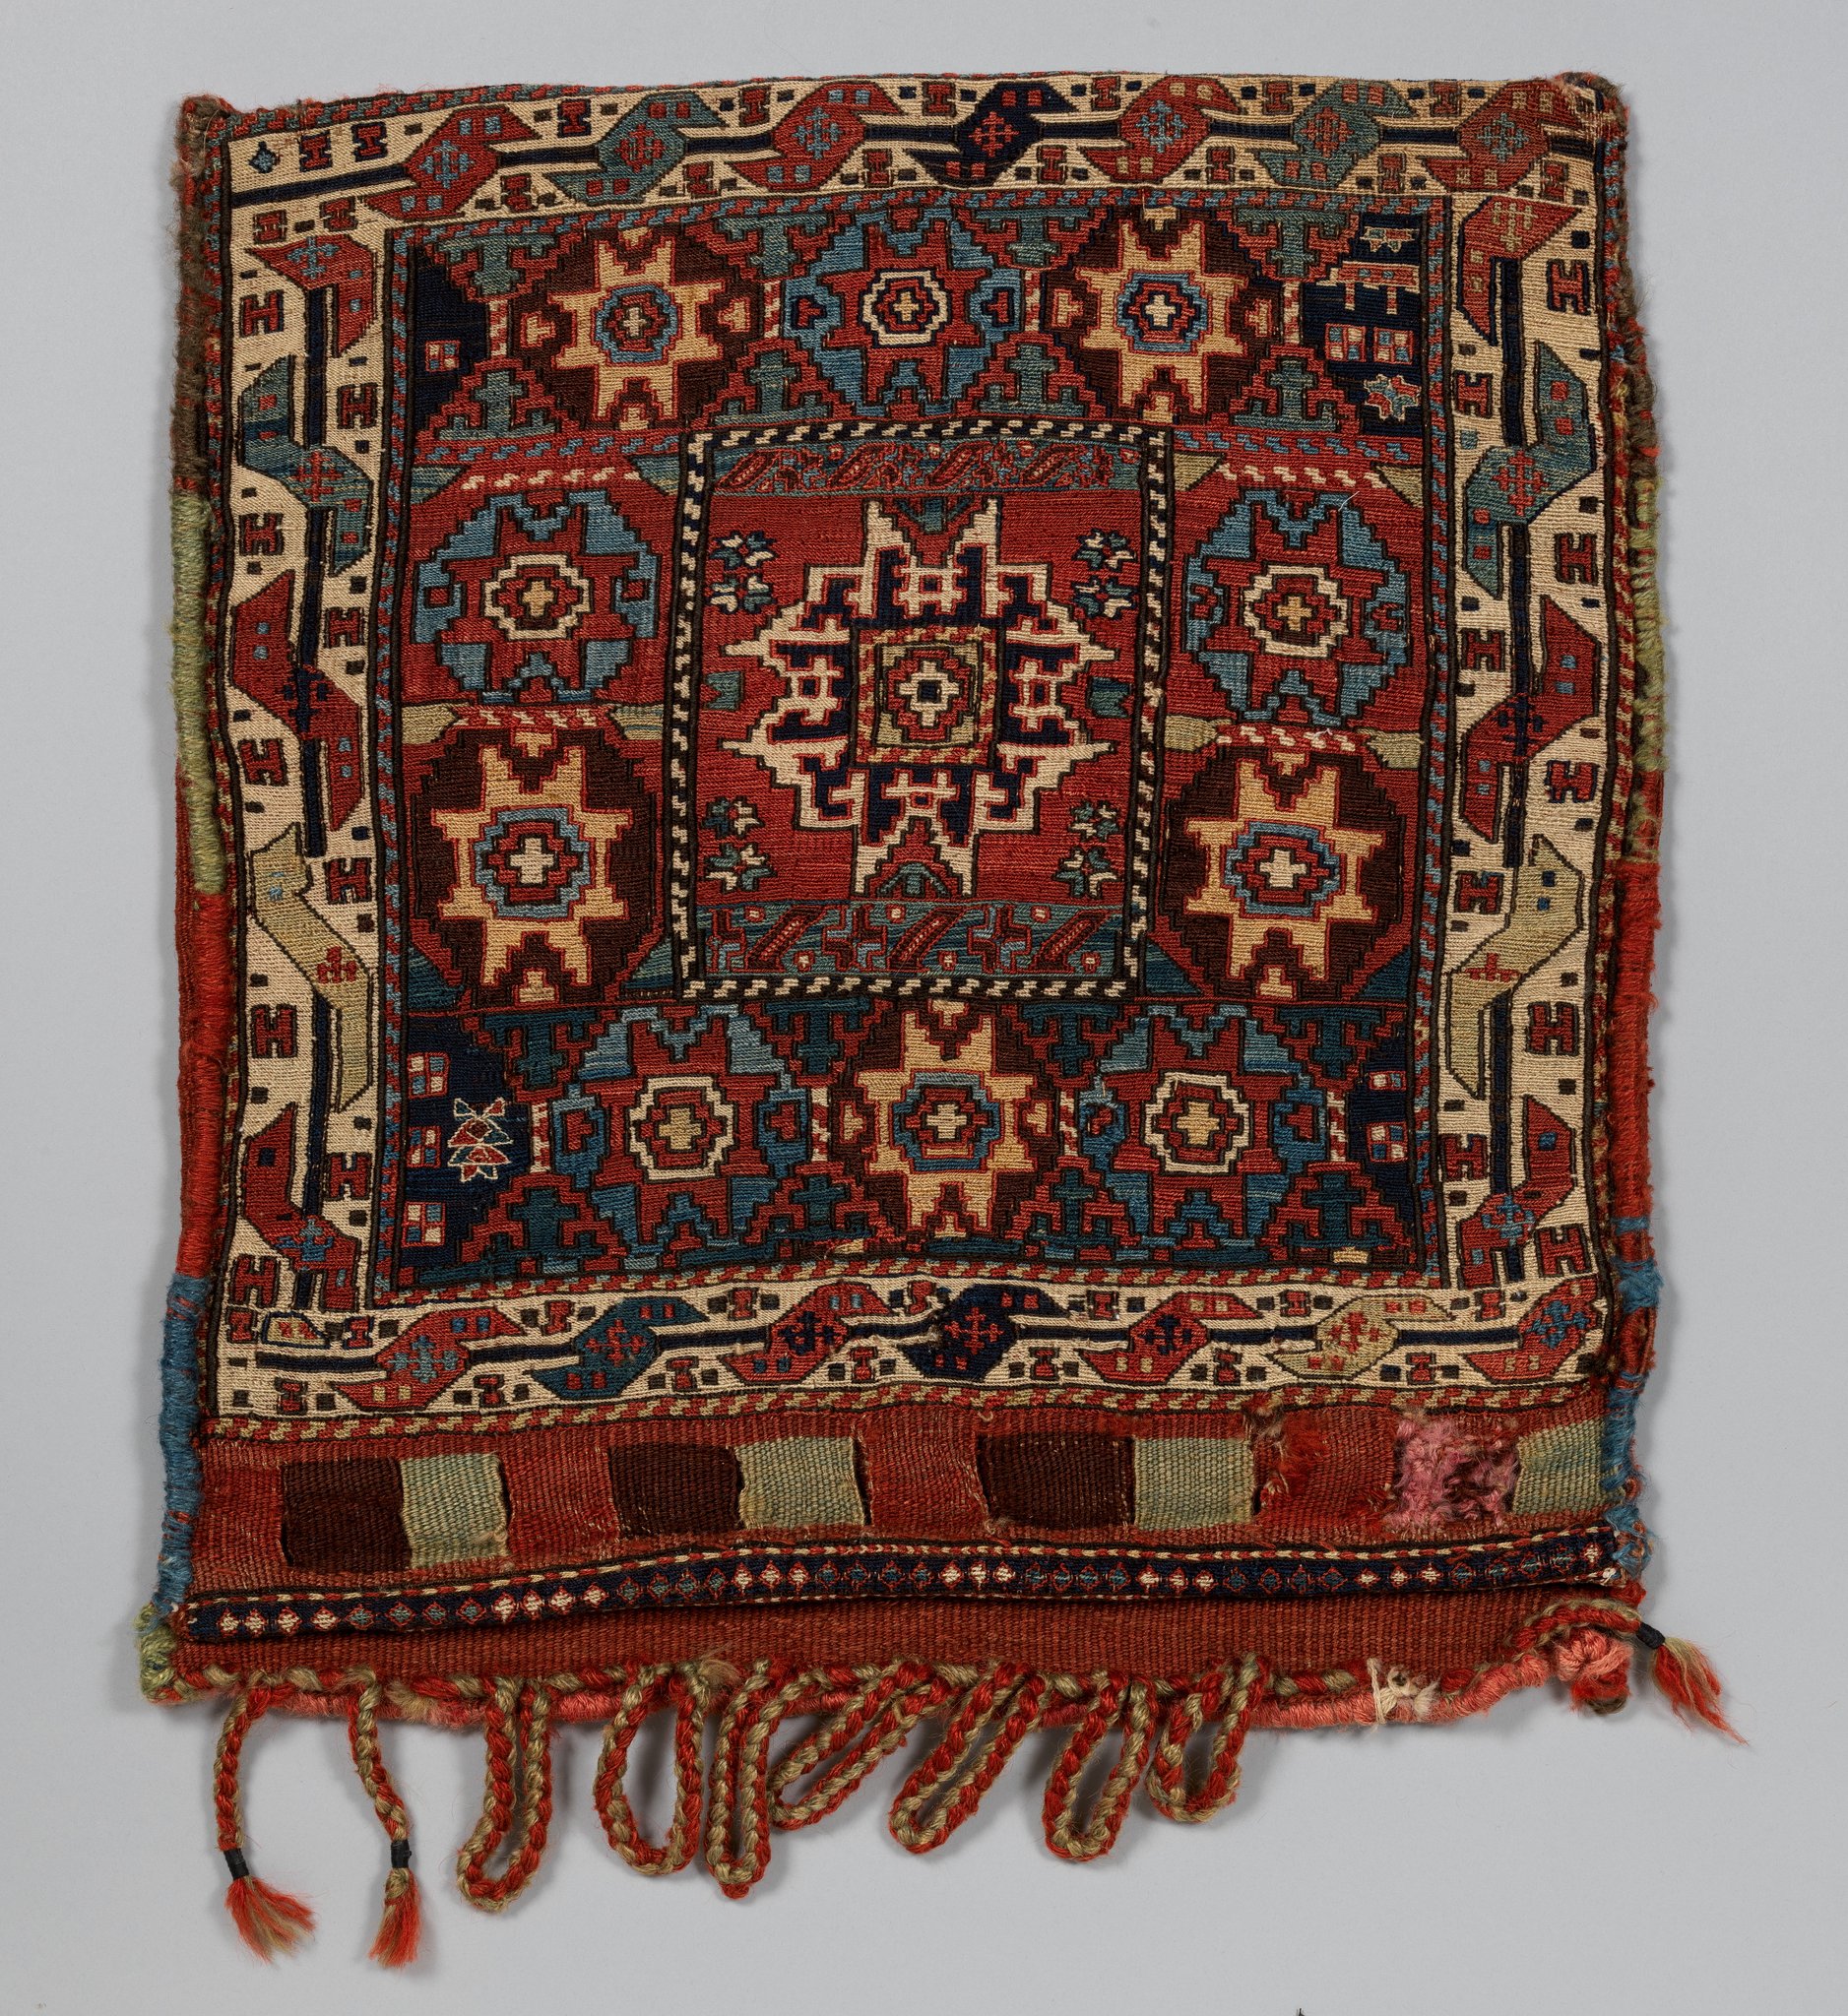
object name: saddle bag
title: Face from Half of Double Saddle Bag (Khorjin)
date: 1801-1900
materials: wool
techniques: brocade, weave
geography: northwestern iran